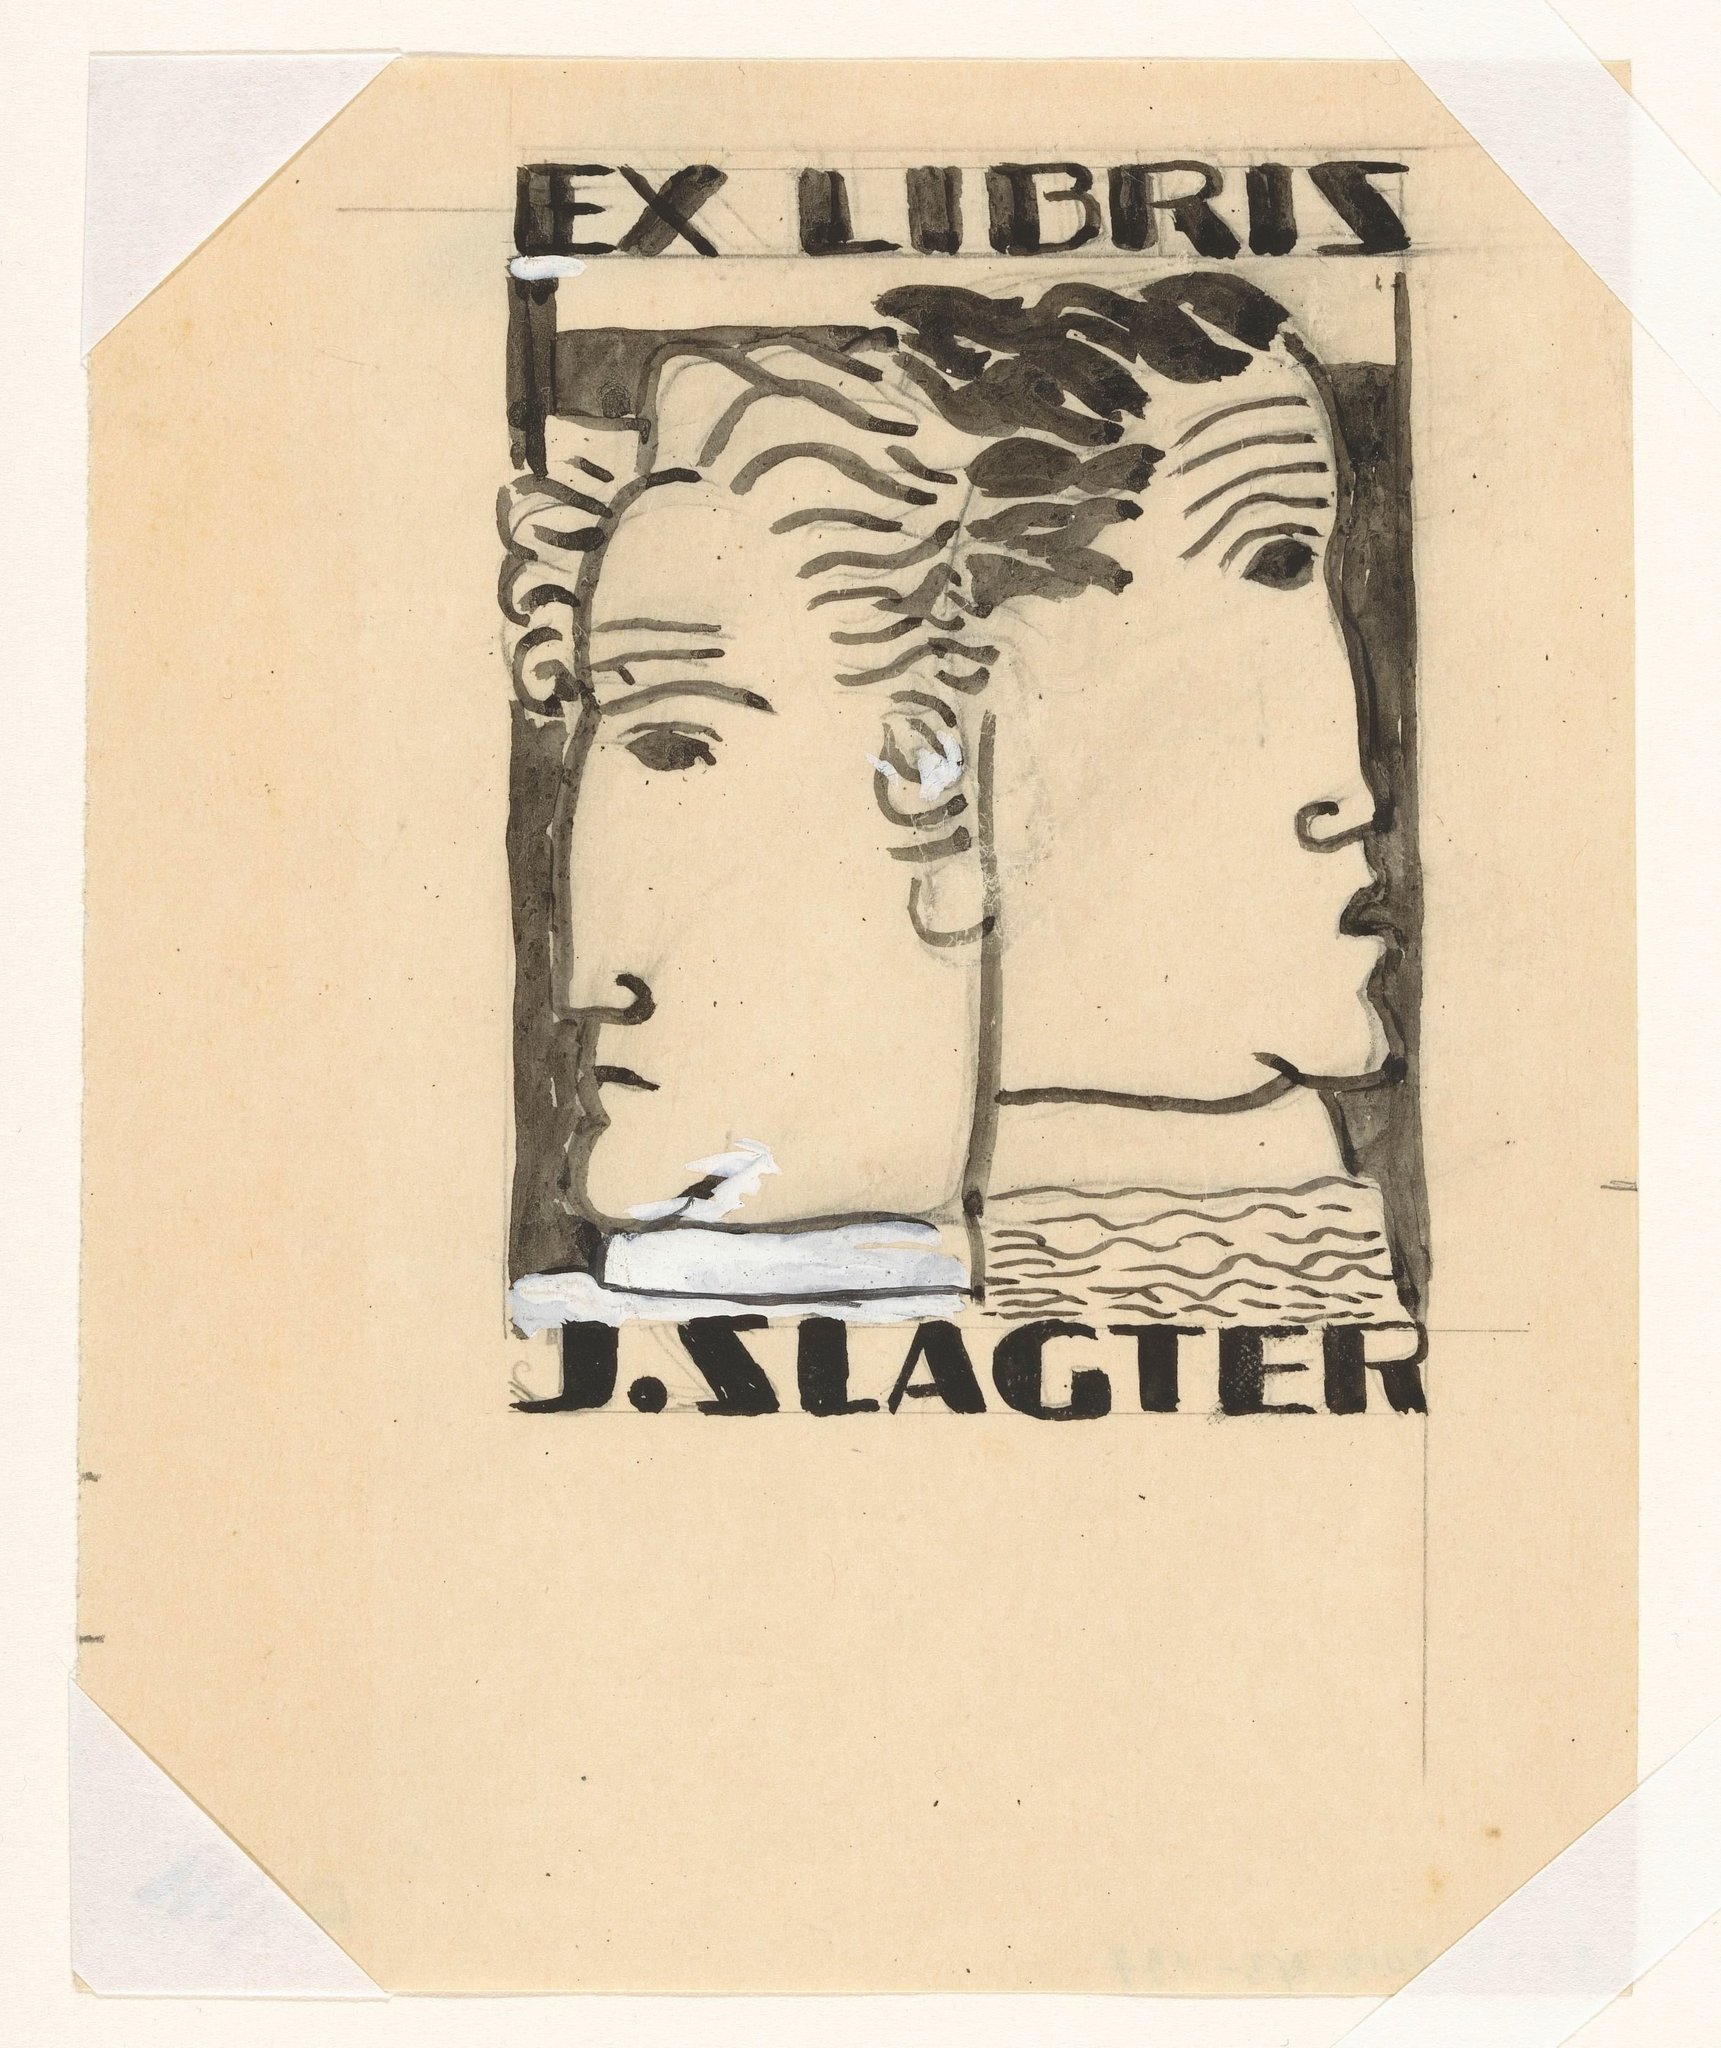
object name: bookplate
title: Ex libris voor J. Slagter (ontwerp)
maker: leo gestel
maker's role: draughtsman, print maker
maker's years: 1881-1941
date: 1935-1940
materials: gouache, ink, paper, pencil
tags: adult man, head turned sideways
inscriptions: title: ‘EX-LIBRIS // J.SLAGTER’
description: Twee koppen en profil, met het achterhoofd naar het midden gewend als een Januskop. De linkerfiguur heeft een witte boord.